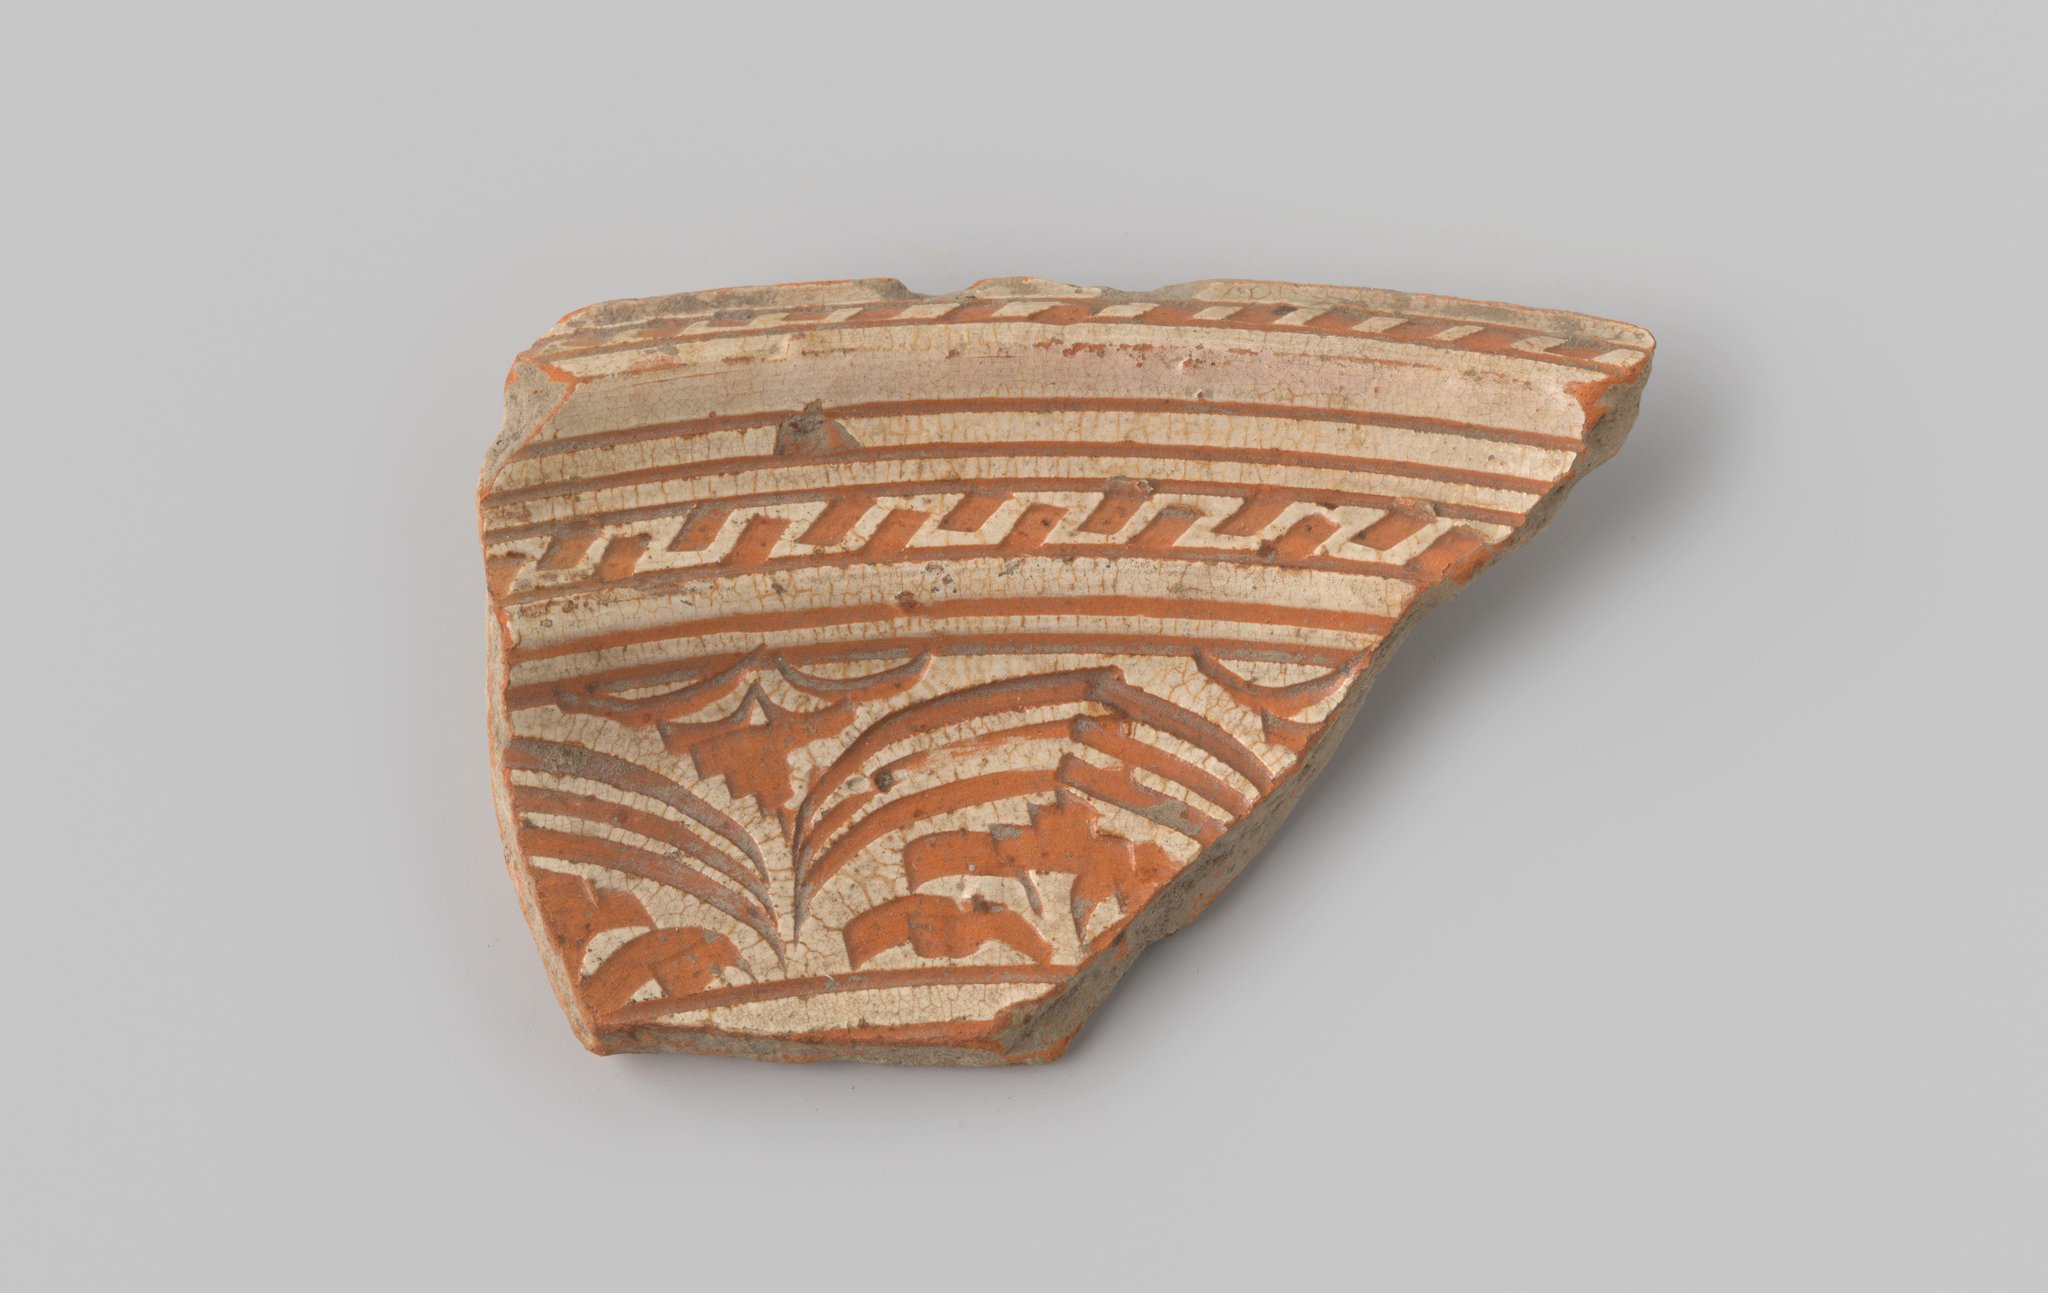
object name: sherd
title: Fragment met rode scherf, aan de bovenzijde voorzien van gestreepte banen in sgrafitto-techniek met wit glazuur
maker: Anonymous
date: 1200-1899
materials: earthenware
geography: italy